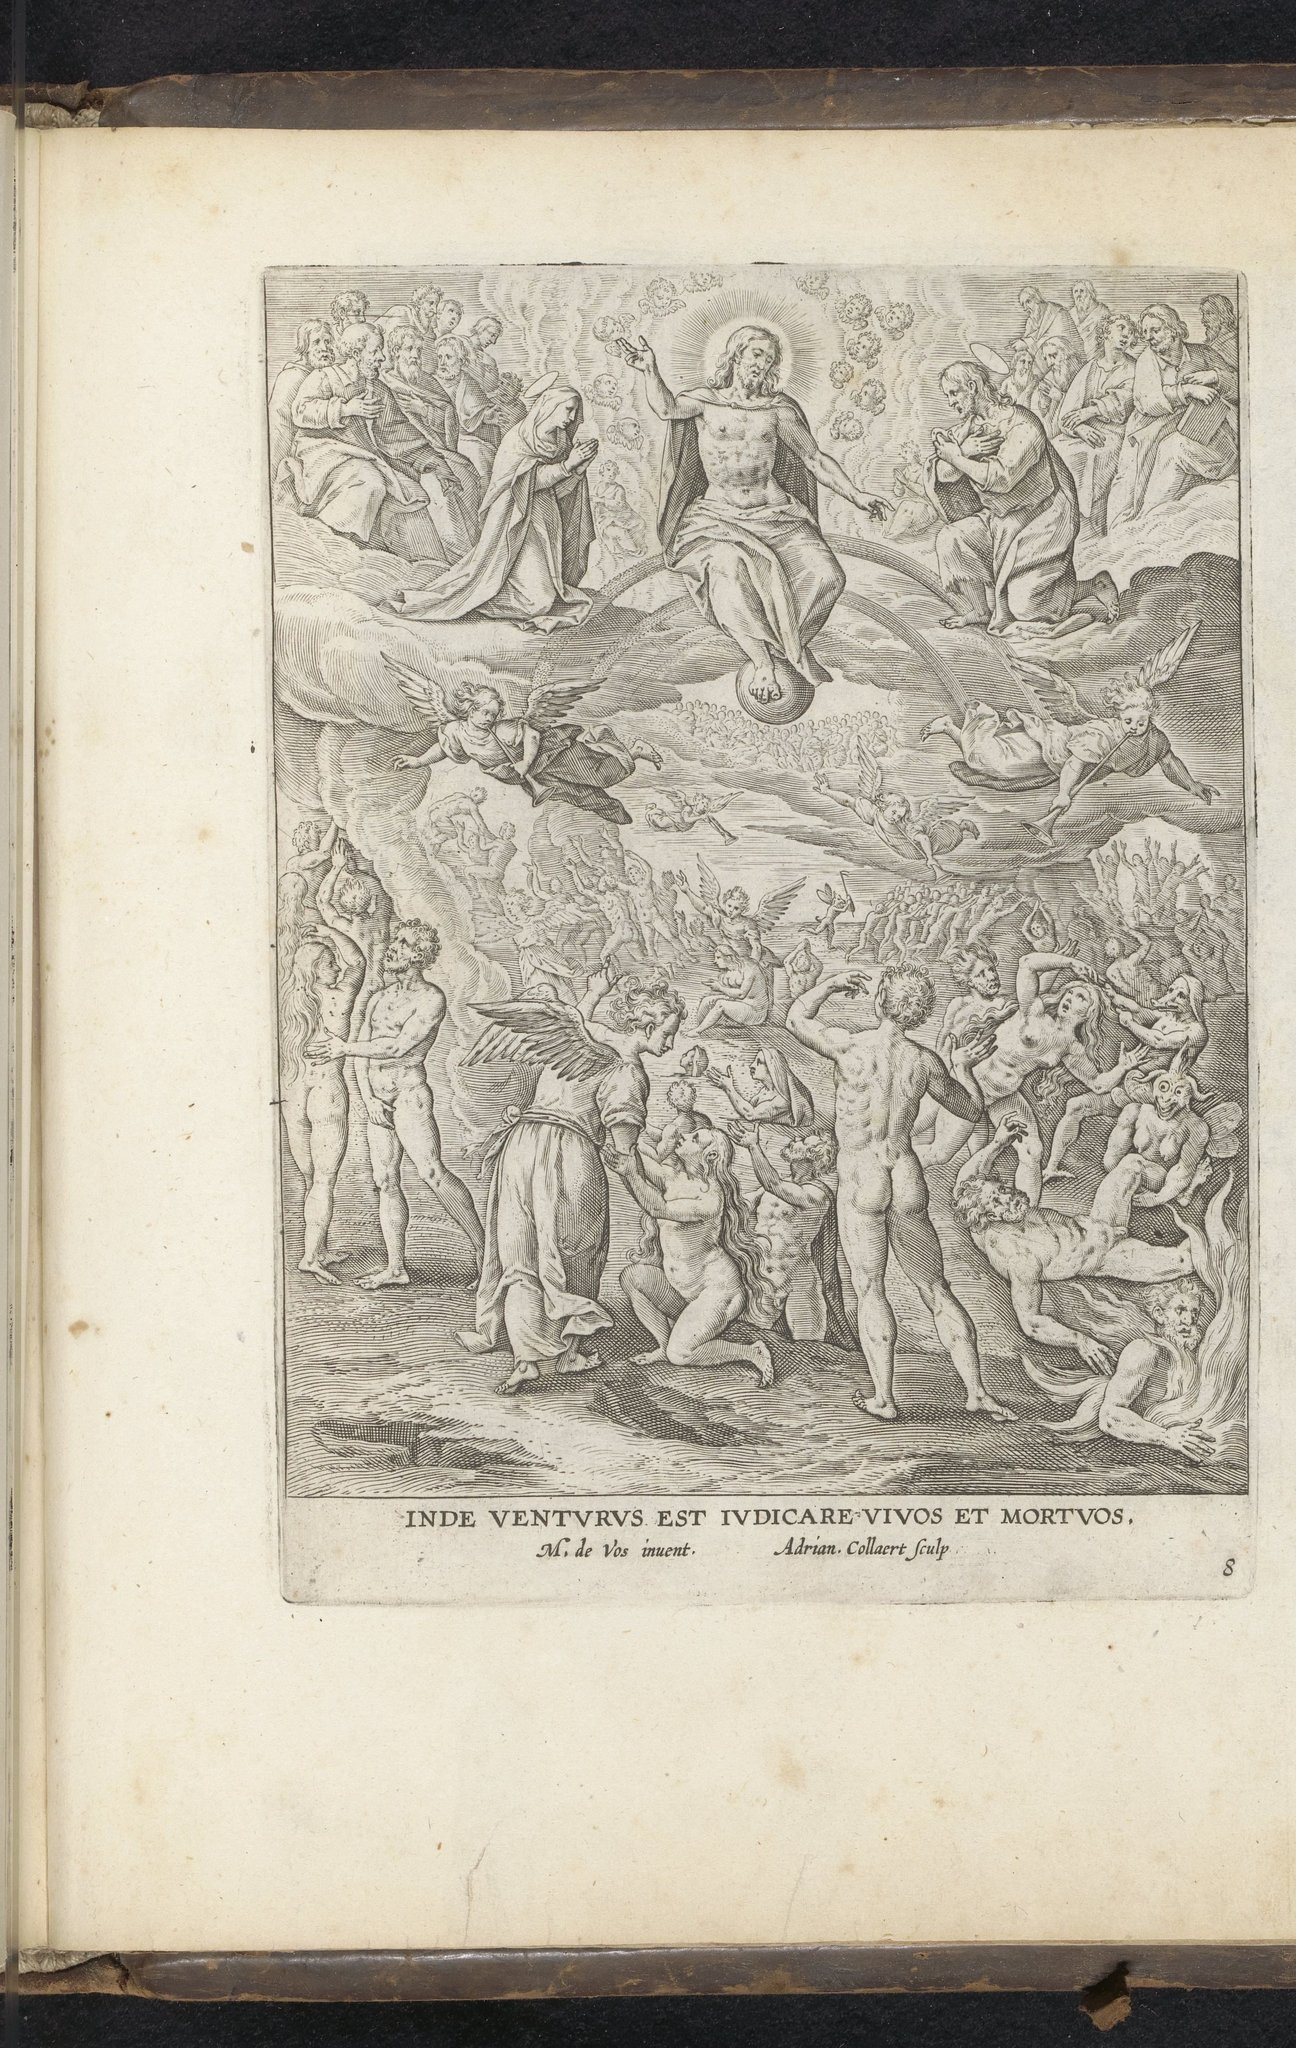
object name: print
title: Den Grooten Figuer-Bibel (...)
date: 1570-1618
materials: paper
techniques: engraving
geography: alkmaar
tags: comprehensive representation of last judgement: christ (with sword and lily), often surrounded by elders and sometimes accompanied by mary and john the baptist, appears in the sky with trumpeting angels (and sometimes angels holding the instruments of the passion); after the resurrection of the dead the blessed are led to heaven by angels, and the damned are dragged into hell by devils, 'inde venturus est iudicare vivos et mortuos' ~ articles of faith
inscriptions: number: ‘203’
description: Illustratie van het zevende geloofsartikel (vandaar zal Hij komen oordelen de levenden en de doden) van de apostolische geloofsbelijdenis. Christus zit op een regenboog in de wolken met de maagd Maria en Johannes geknield naast hem. Hij oordeelt over de wereld tijdens het Laatste Oordeel. Rondom hen de apostelen. Op de aarde herrijzen alle doden uit hun graven. Zij worden door engelen naar de hemel geleid (links) of door duivels naar de hel gevoerd (rechts). Deze prent maakt deel uit van een album.